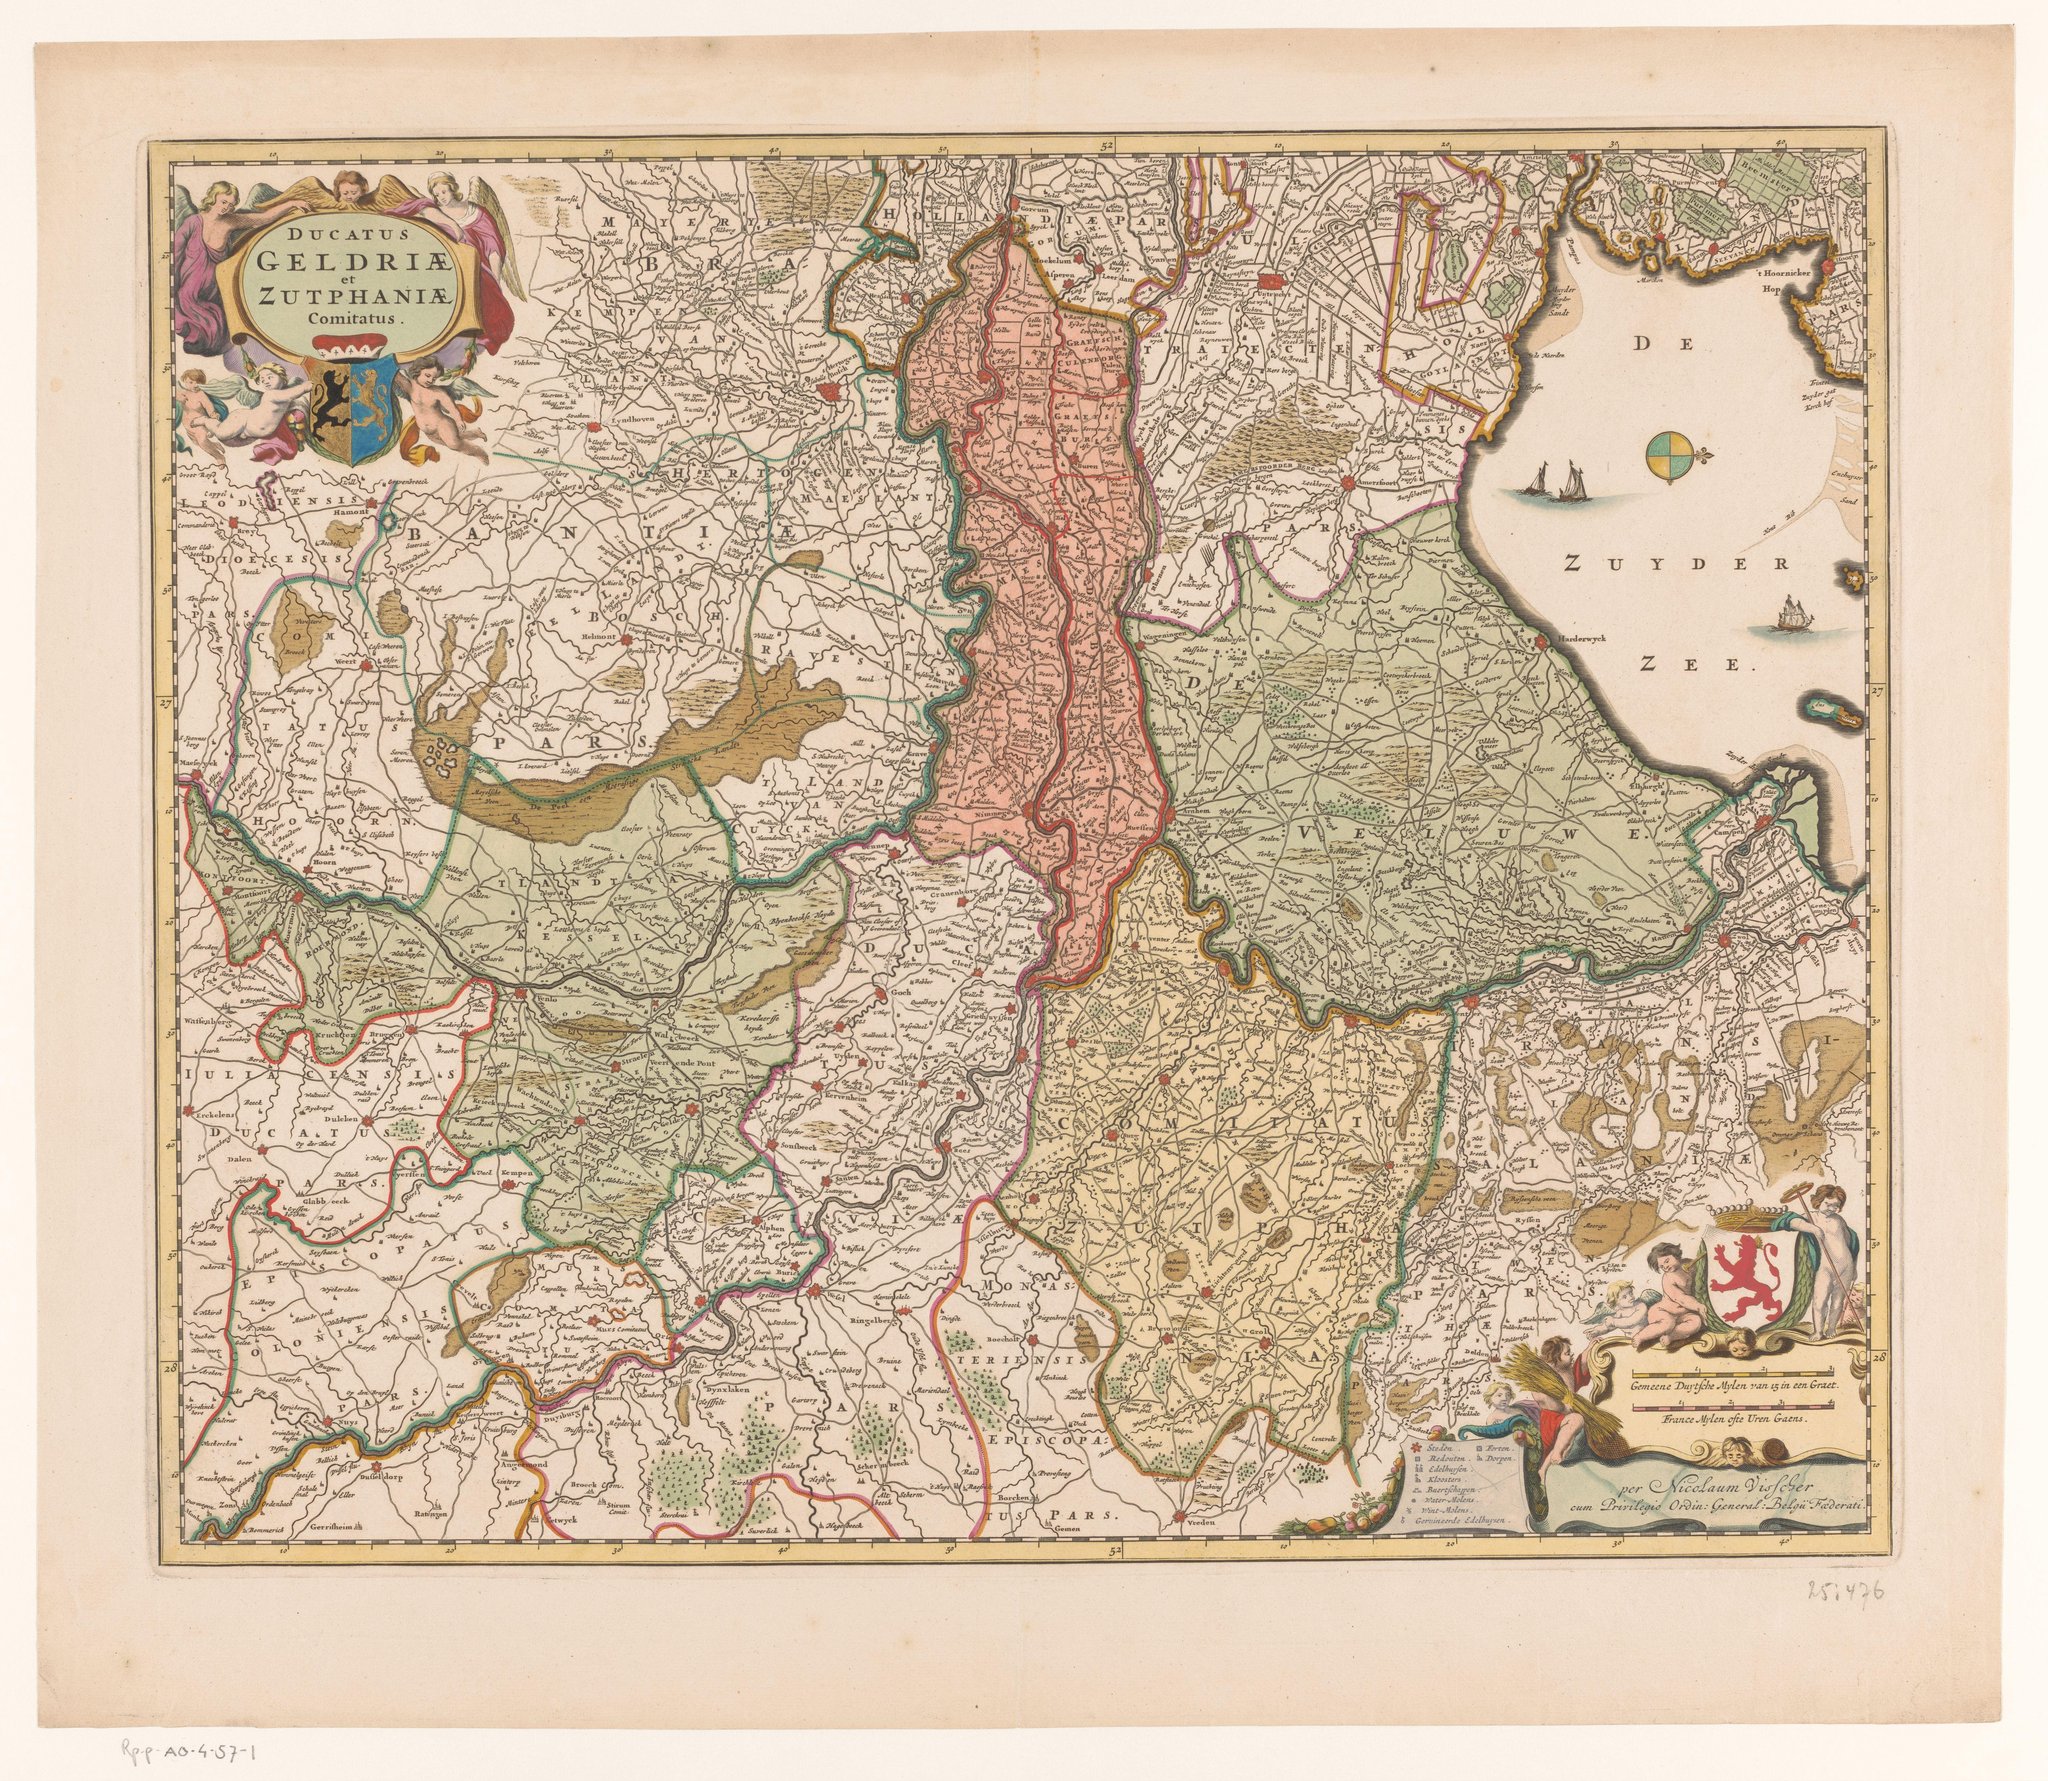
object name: map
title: Ducatus Geldria et Zutphania comitatus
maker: Anonymous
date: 1677-1720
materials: paper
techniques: engraving, etching, hand coloring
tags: maps of separate countries or regions, coat of arms (as symbol of the state, etc.) (+ province; provincial), gelderland, guelders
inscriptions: collector's mark: Lugt 2228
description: Linksboven de titelcartouche, met onderin het wapen van Gelre. Rechtsonder een cartouche met twee schaalstokken: 3 Gemeene Duytsche Mylen van 15 in een Graet / 4 France Mylen ofte Uren Gaens. Hierboven het wapen van het graafschap Zutphen, links de legenda. De kaart is voorzien van een gradenverdeling langs de randen.